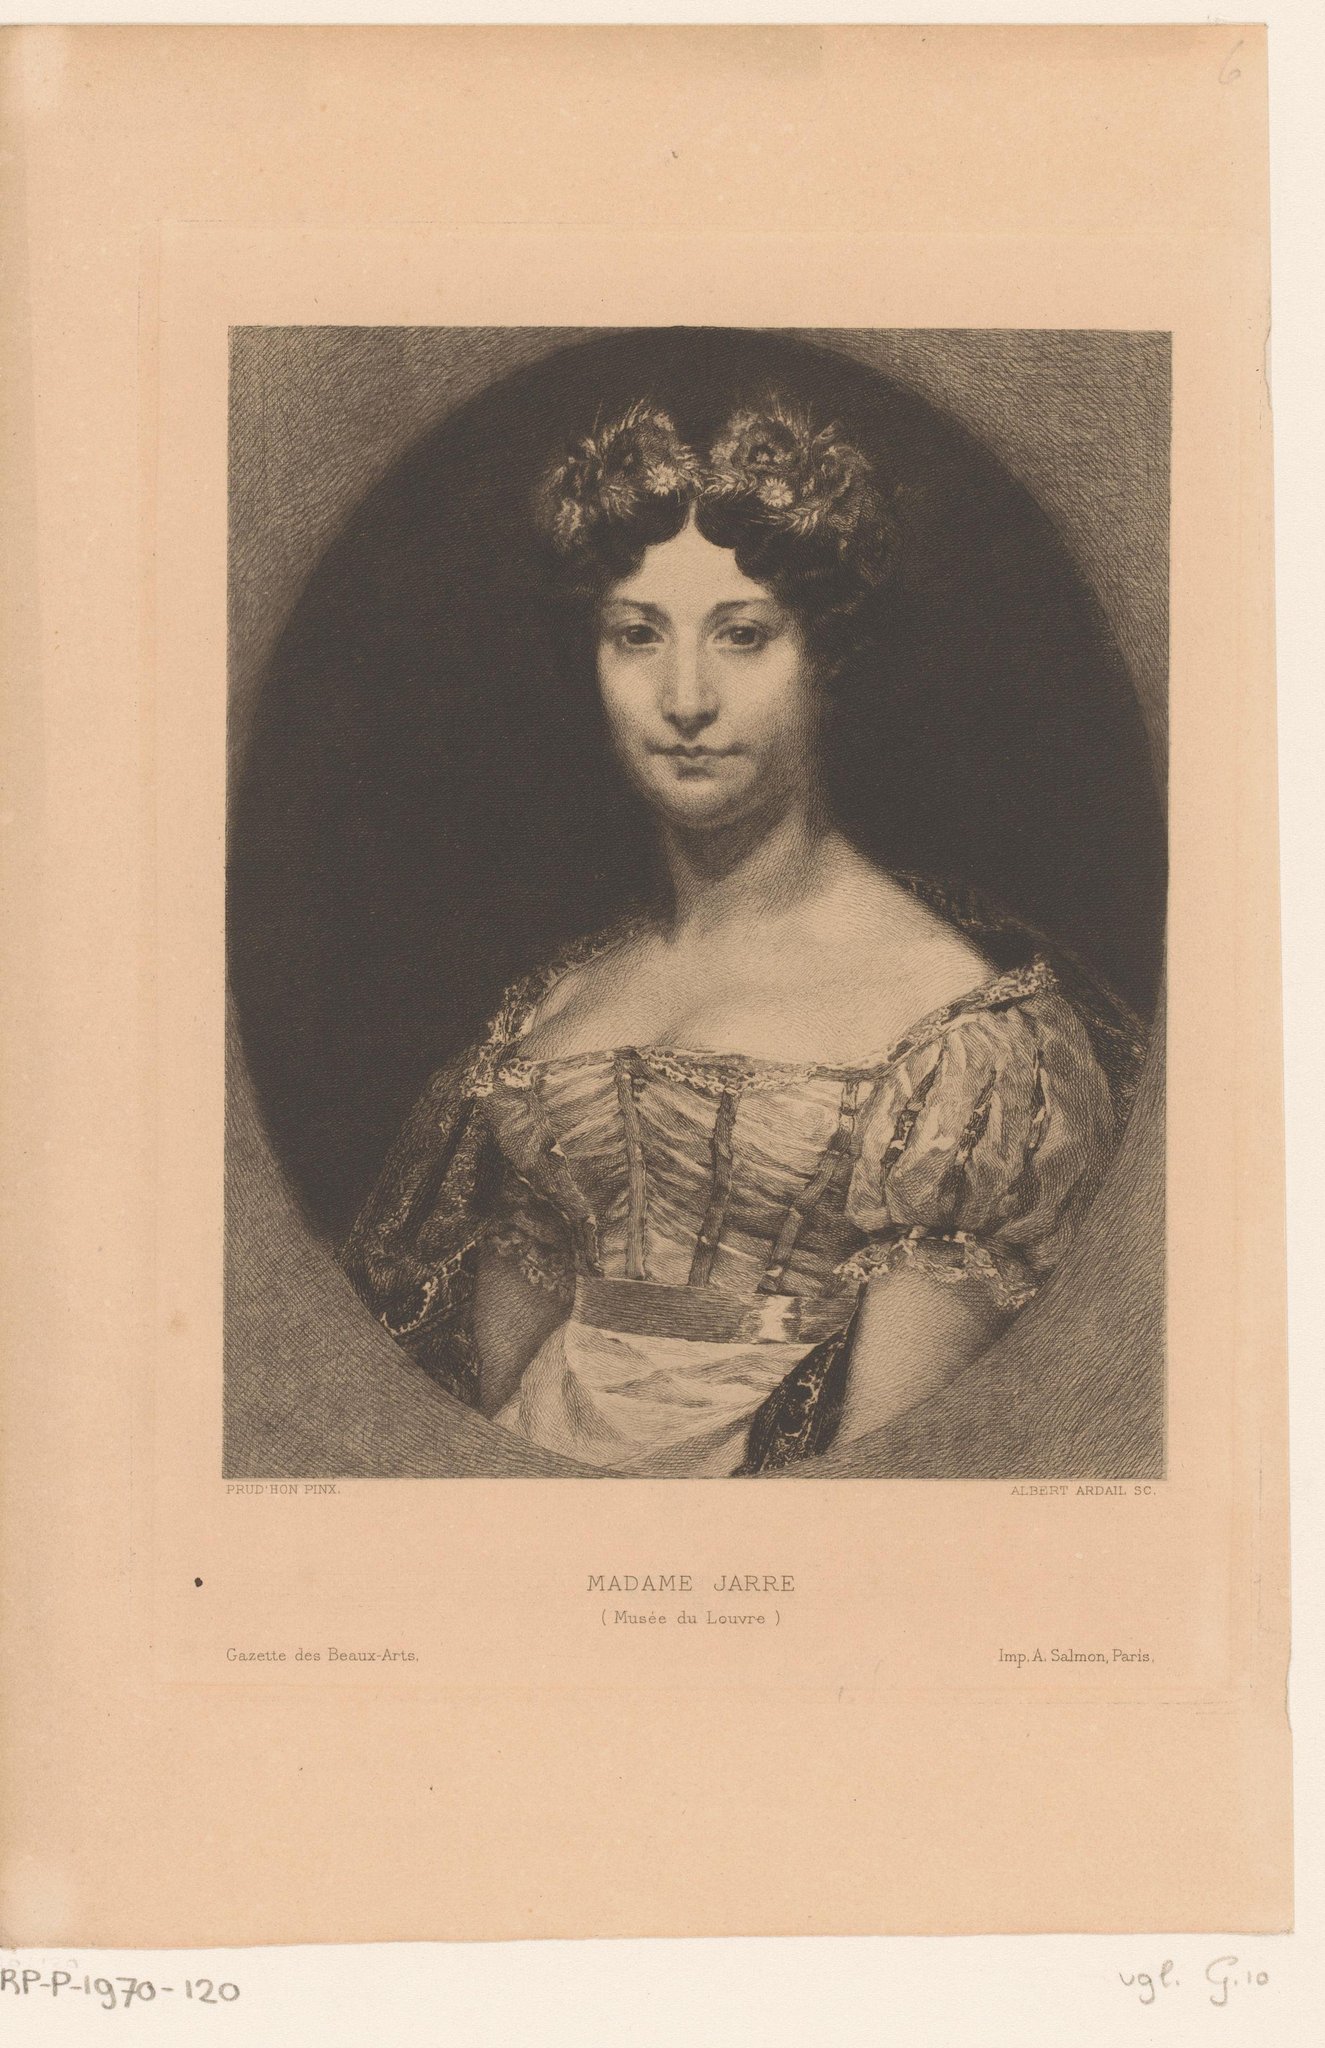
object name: print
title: Portret van Henriette Marguerite Madeleine Jarre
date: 1886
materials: paper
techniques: etching, intaglio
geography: paris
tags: historical persons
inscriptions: collector's mark: Lugt 2760, collector's mark: Lugt 2228a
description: Prent uit: Gazette des Beaux-Arts, nr. 343, 1 januari 1886.